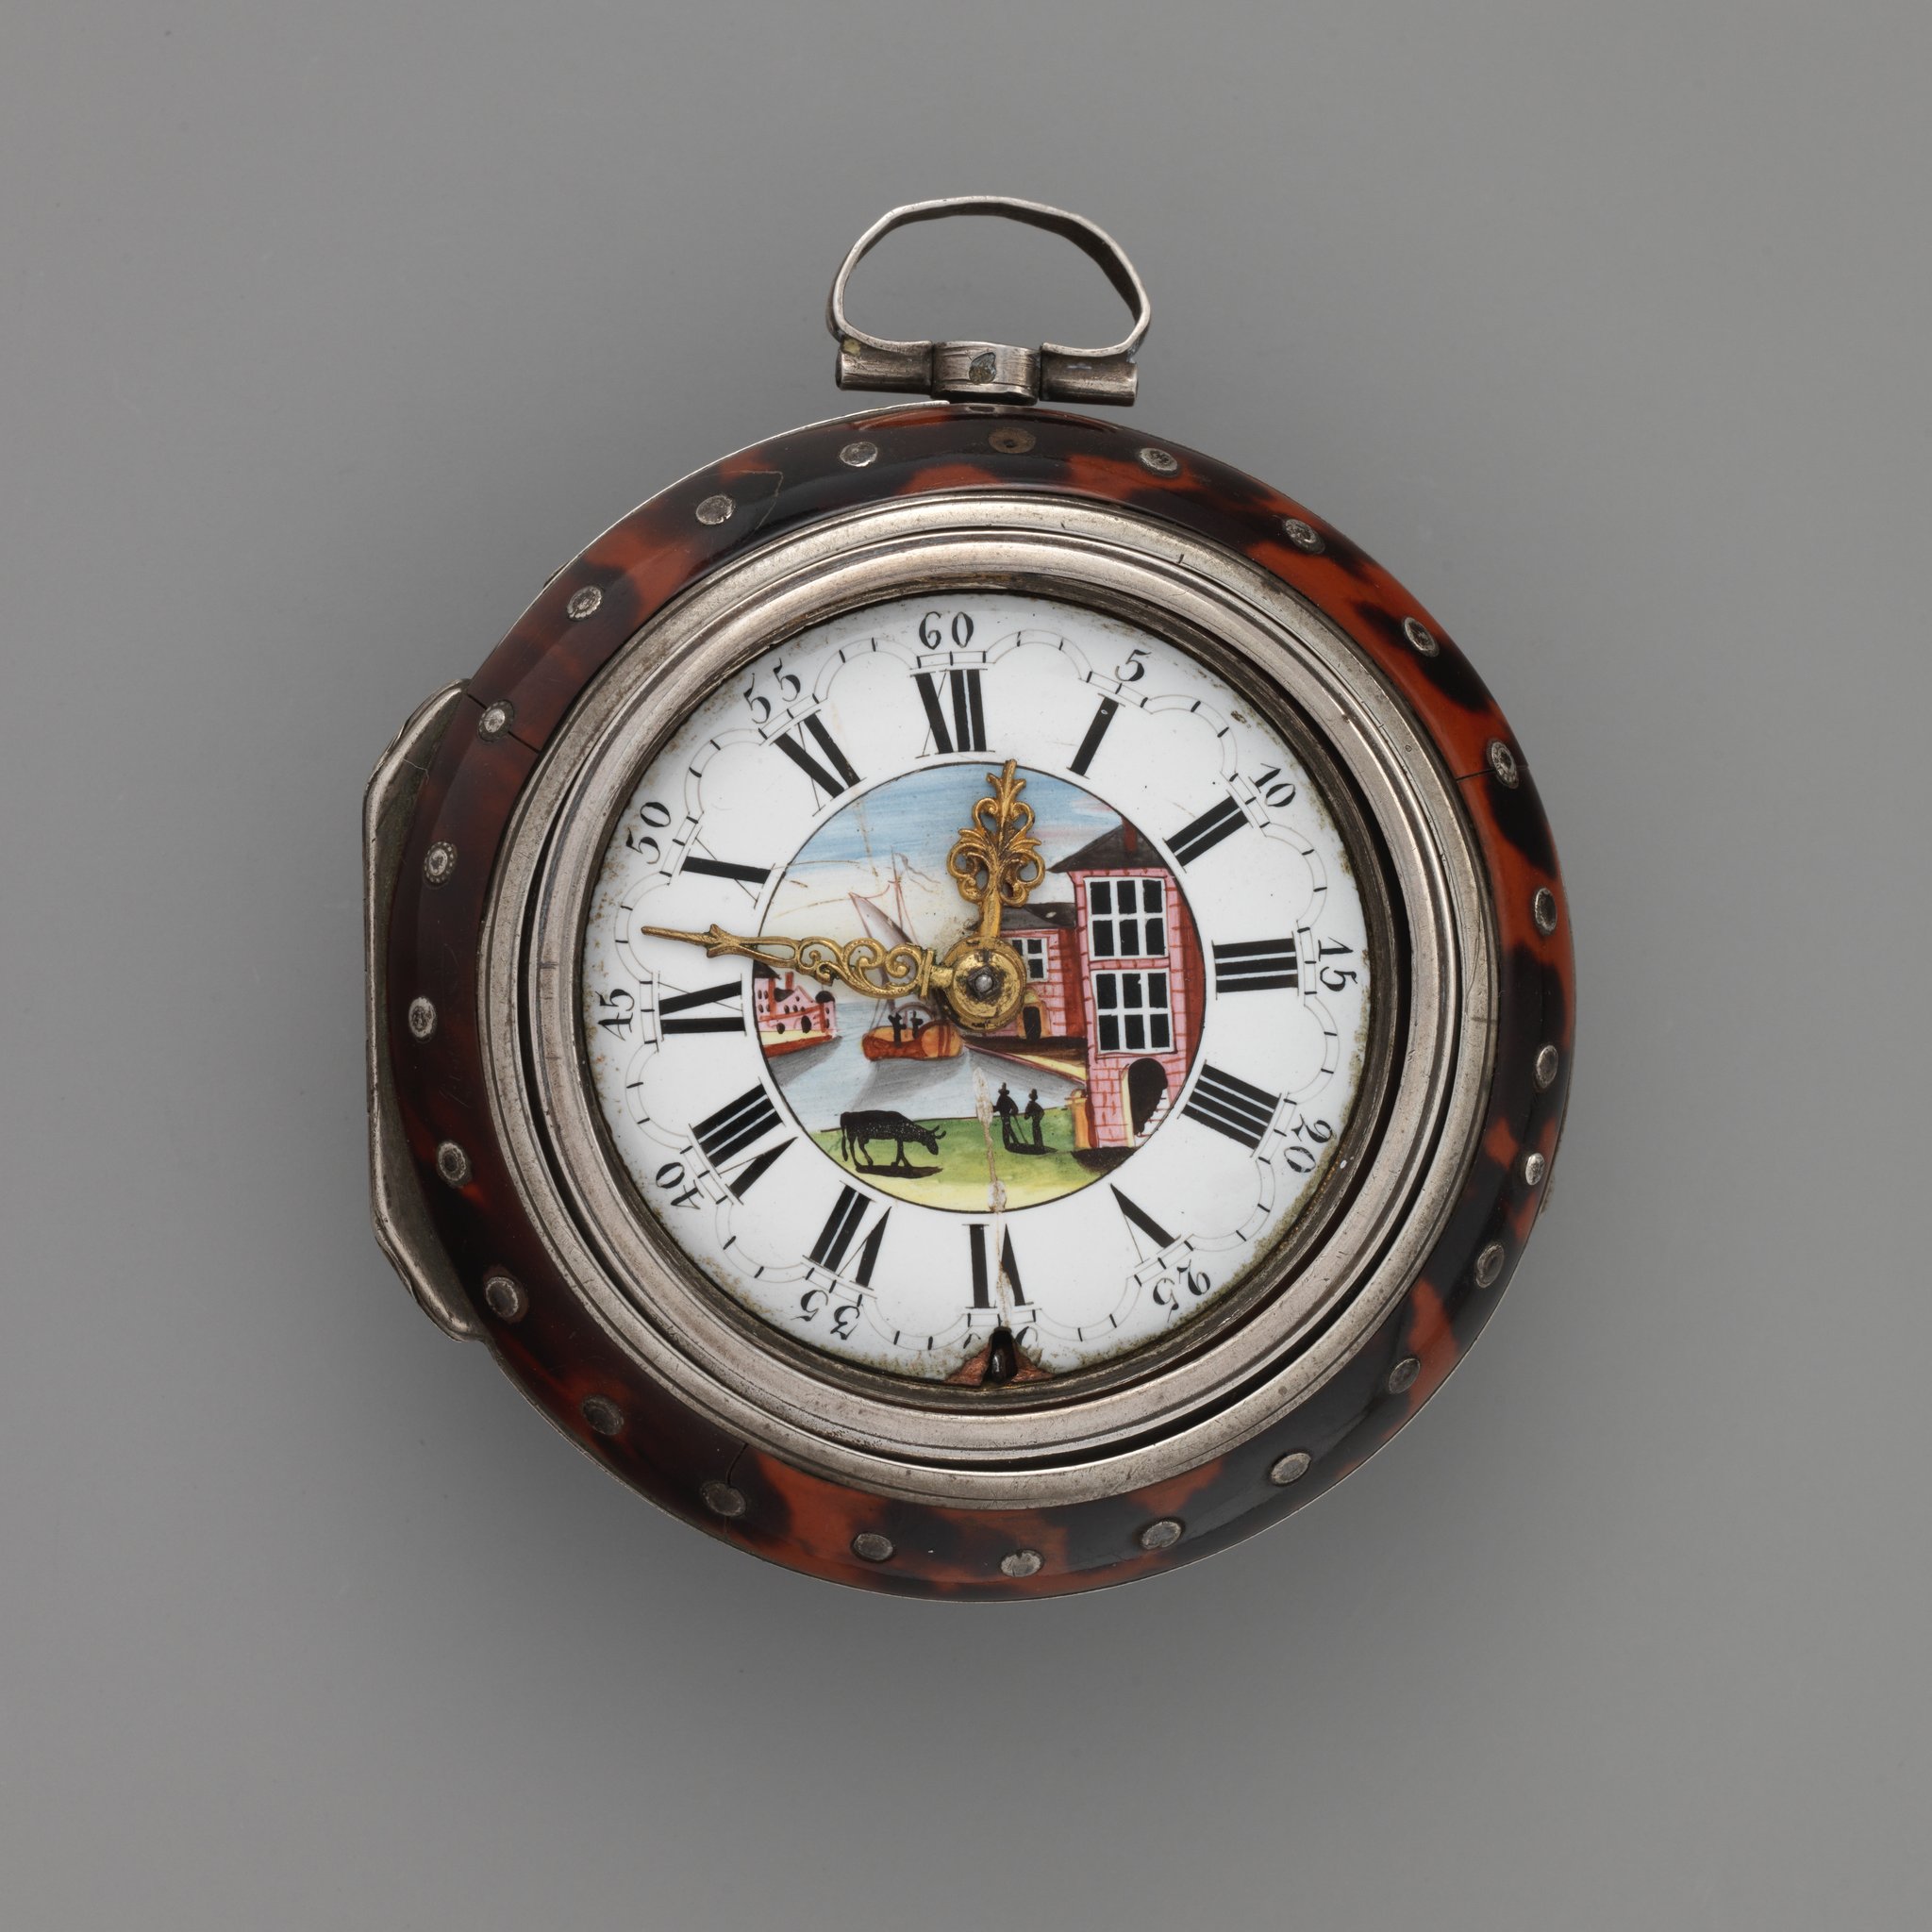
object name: watch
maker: nicholas walter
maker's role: maker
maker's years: 1620-1630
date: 1667-1700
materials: enamel, silver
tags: animals,houses,boats